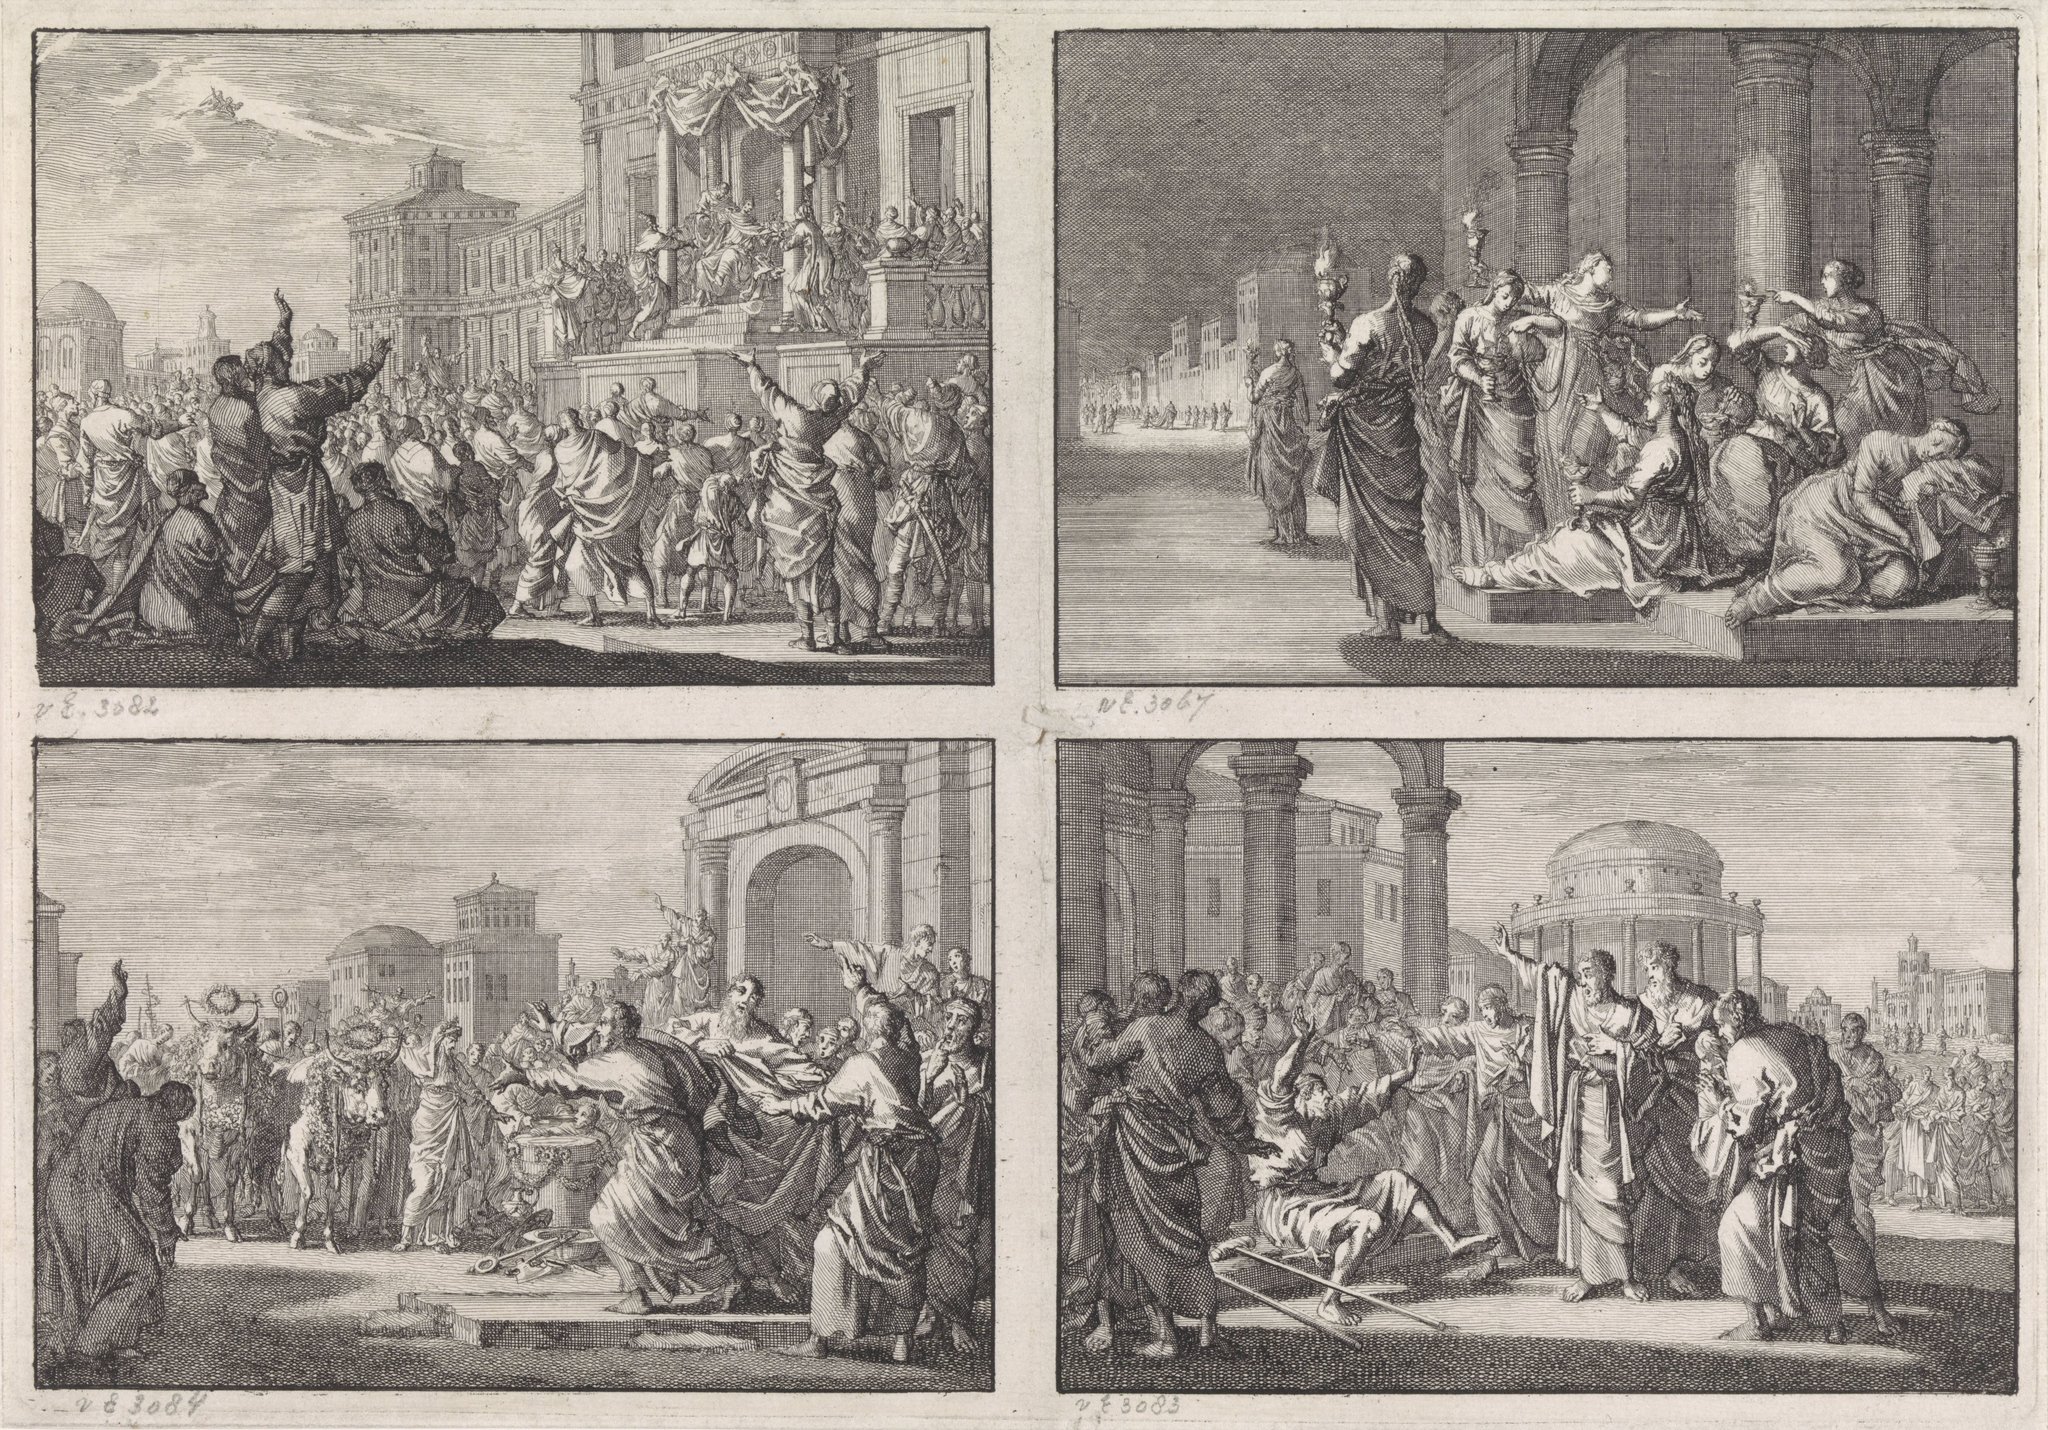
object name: print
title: Vier voorstellingen uit het Nieuwe Testament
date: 1703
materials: paper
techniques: etching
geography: amsterdam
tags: paul and barnabas tear their clothes, and try to prevent the sacrifice, the wise and the foolish virgins ~ parable of christ (matthew 25:1-13), paul and barnabas heal the feet of a man; the people of lystra think they are mercury and jupiter, king herod agrippa speaks to the people; he is smitten by an angel and dies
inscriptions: collector's mark: Lugt 2228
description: Proefdruk van boekillustraties voor David Martin. Historie des Ouden en Nieuwen Testaments. Amsterdam, Pieter Mortier, 1703. Deel II. De boekillustraties voor de Mortierbijbel hebben verschillende staten en kopieën, waarbij de chronologische volgorde moeilijk te achterhalen valt. Als boekillustraties werden ze bovendien herhaaldelijk opnieuw gebruikt voor andere boekwerken.